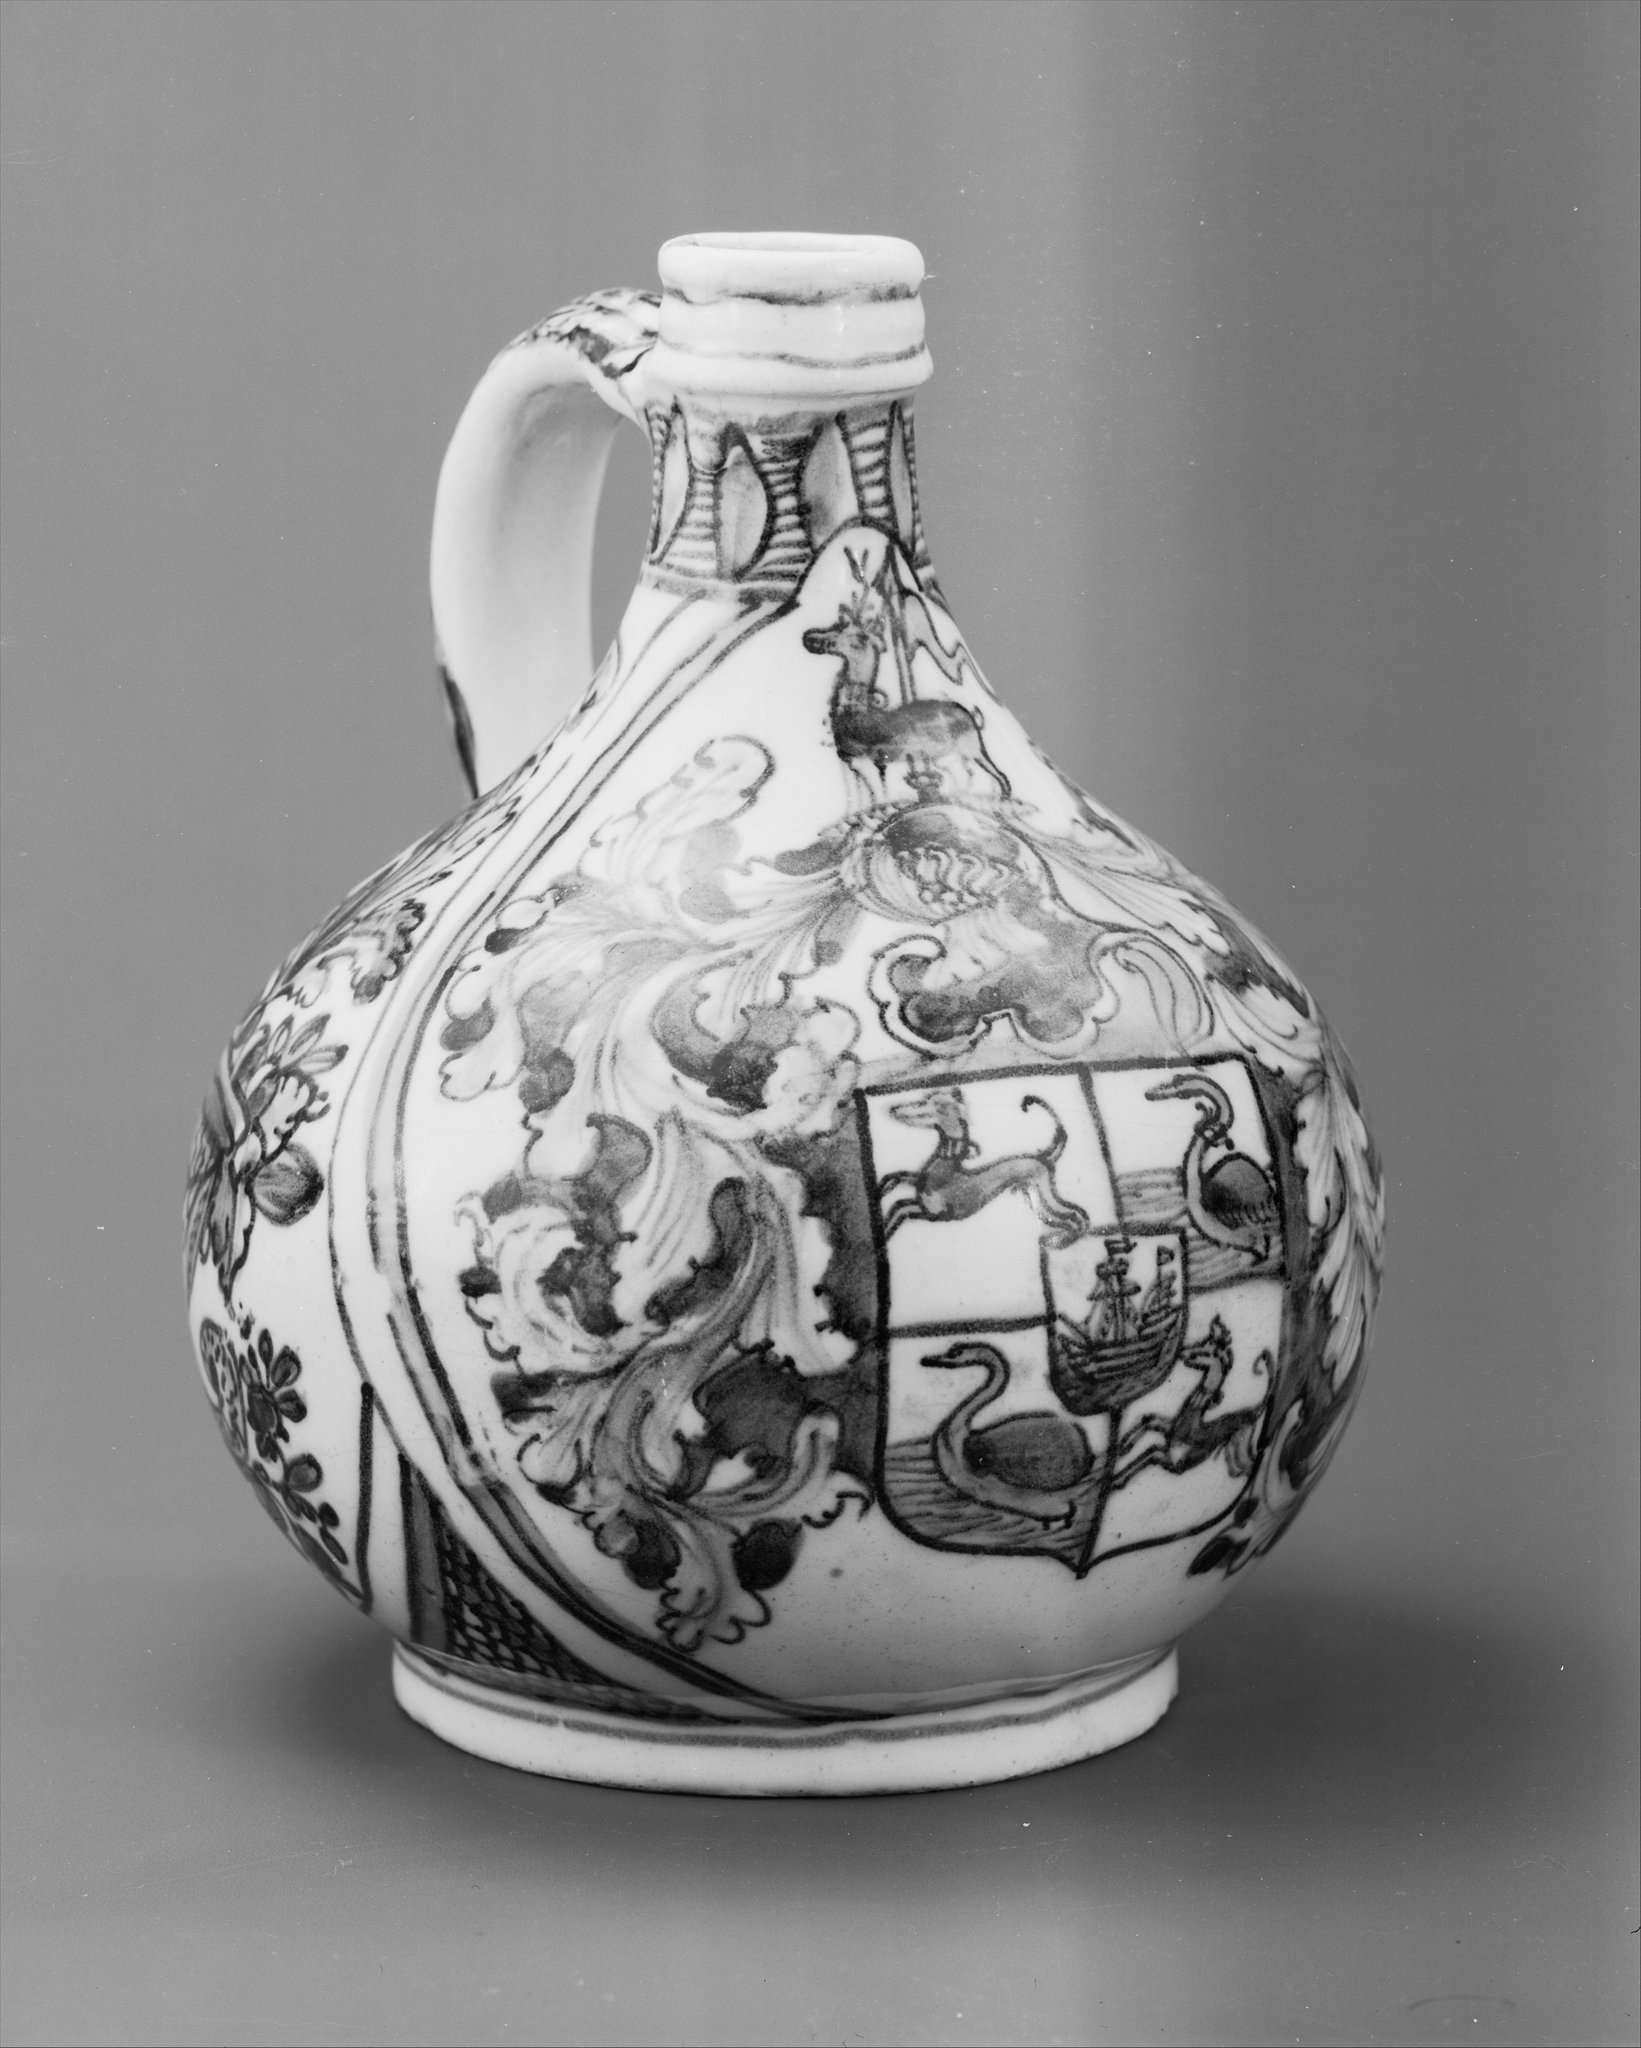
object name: bottle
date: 1601-1700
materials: faience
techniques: glazing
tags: animals,birds,deer,coat of arms